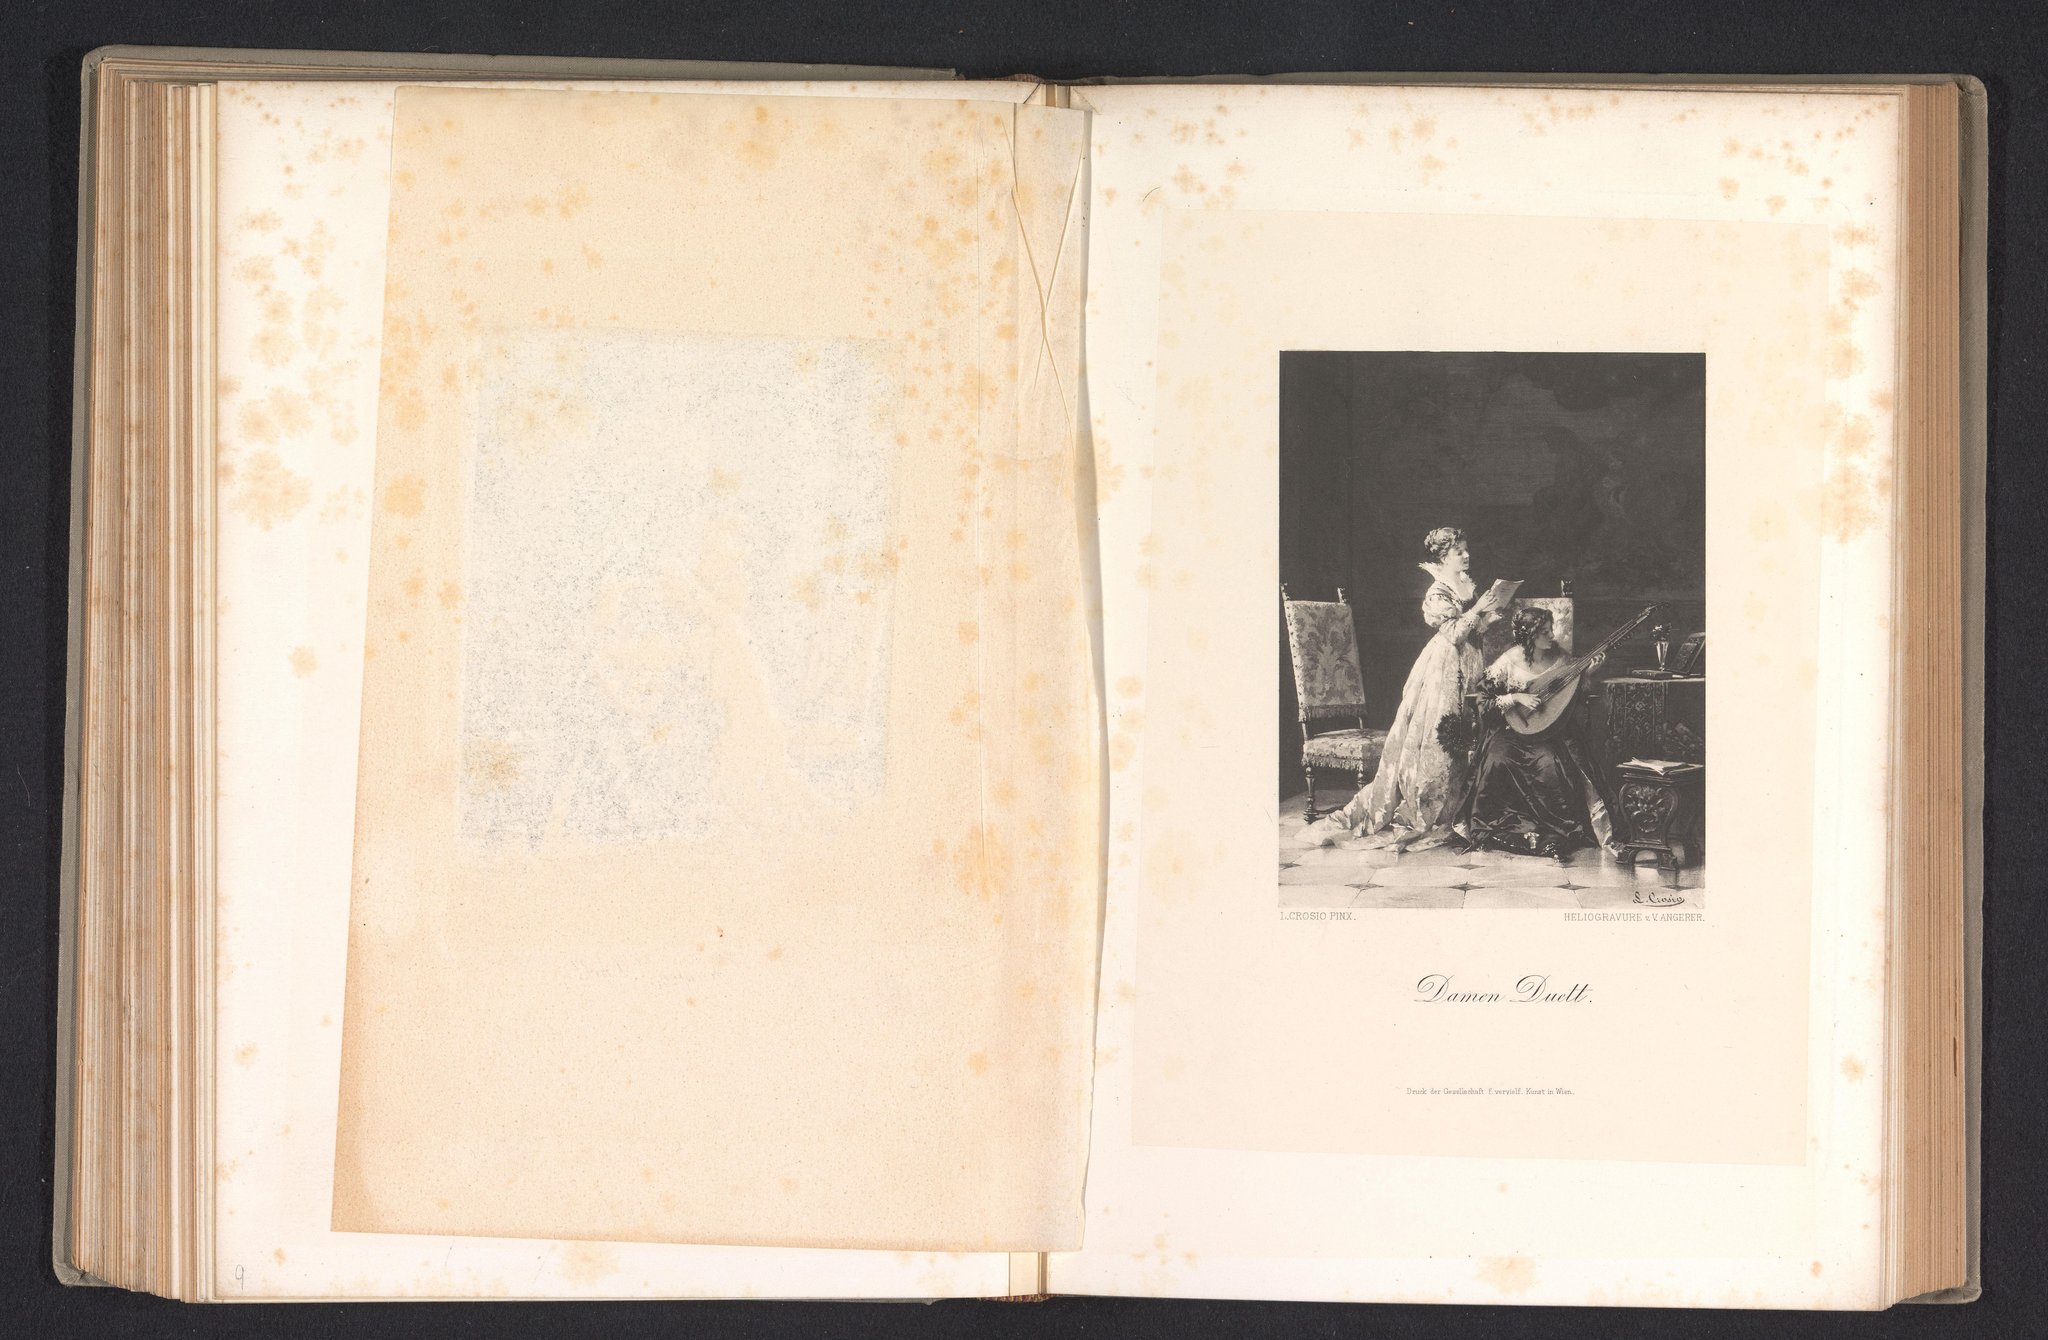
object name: reproduction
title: Damen Duett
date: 1878-1883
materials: paper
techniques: photoaquatint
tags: musician(s) accompanying singer(s), vocal music, singing, lute, and special forms of lute, e.g.: theorbo